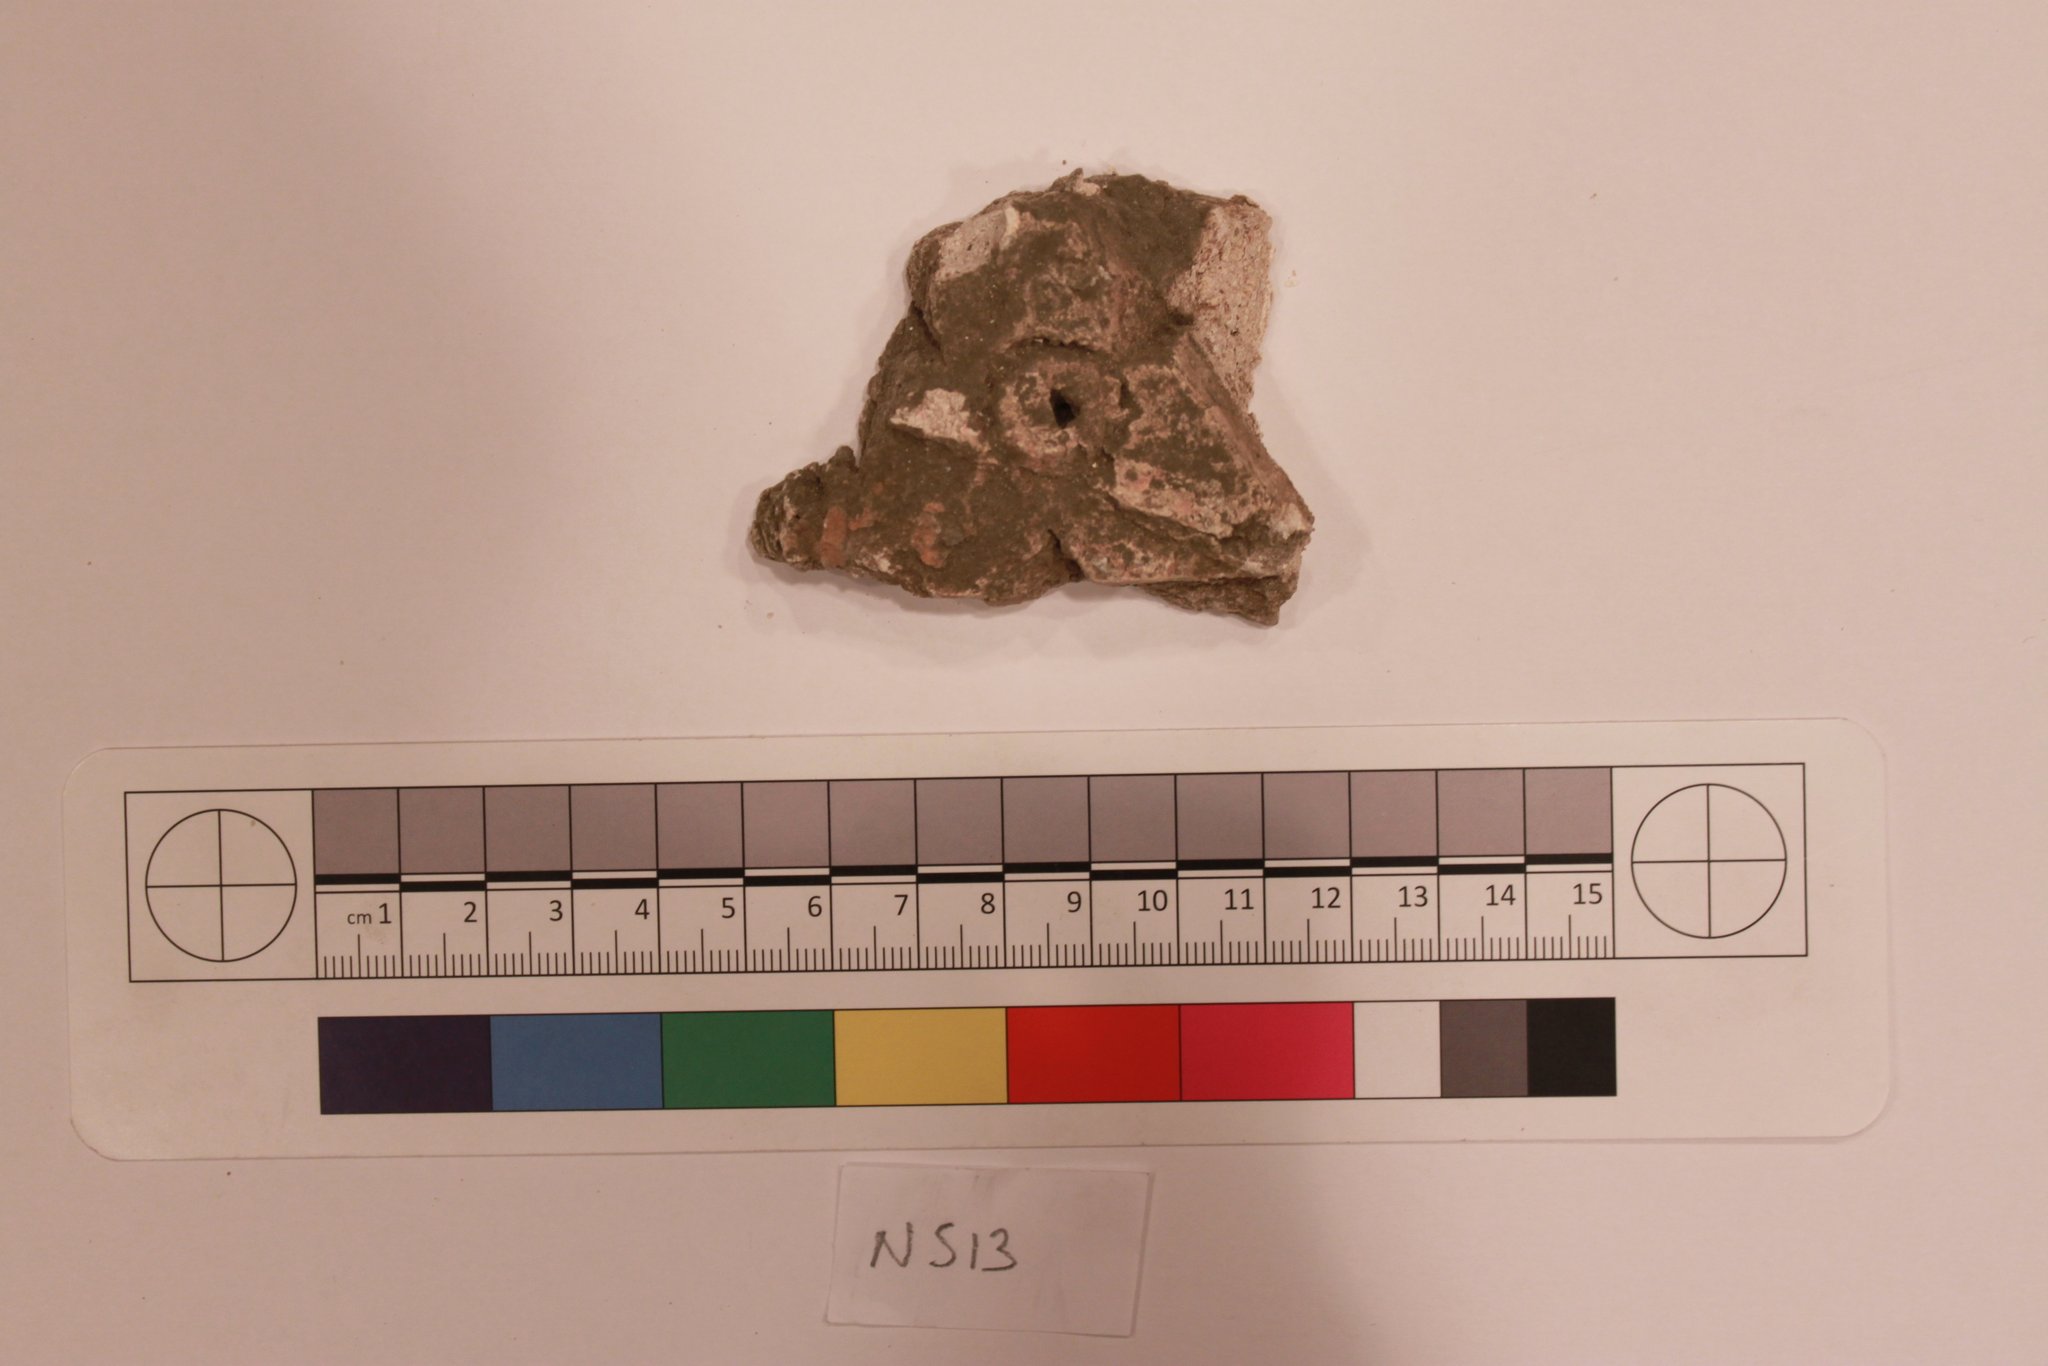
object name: fragment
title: Stucco Fragment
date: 701-1200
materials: plaster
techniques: carving, painting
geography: iran